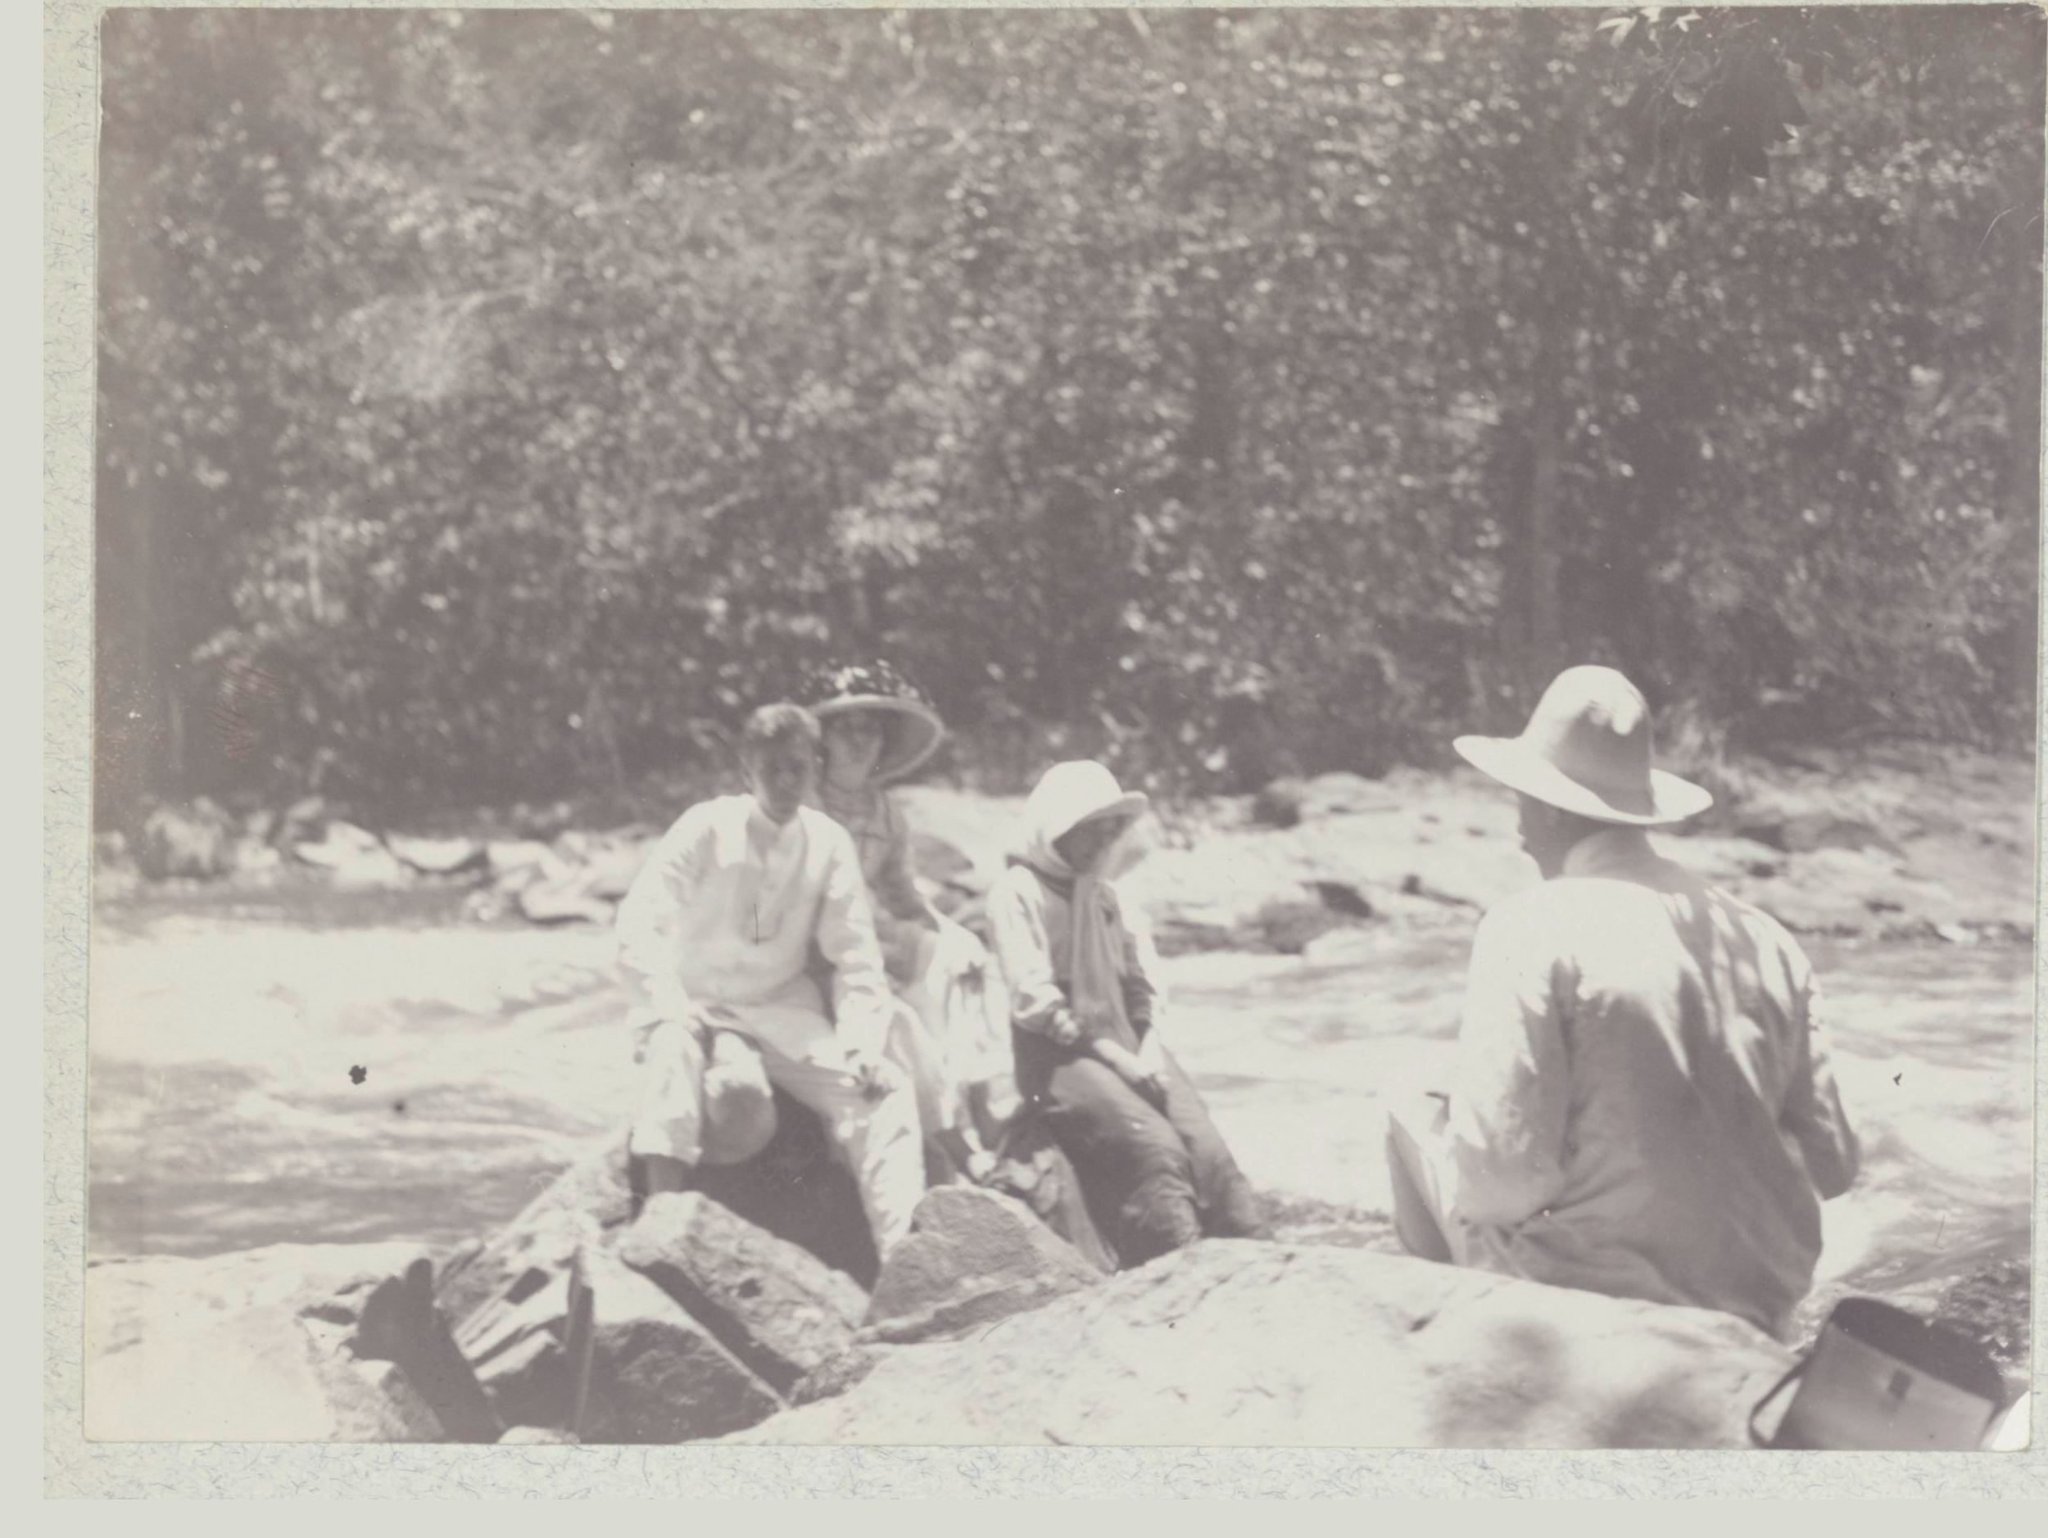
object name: photograph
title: Sarakreek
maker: Anonymous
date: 1909-1911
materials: photographic support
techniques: photography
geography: suriname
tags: suriname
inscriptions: inscription: ‘Sarakreek, Suriname. 1911’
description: Gezelschap bij de rotsen aan de waterkant van de Sarakreek, september 1911. Onderdeel van het fotoalbum van de familie Boom-Gonggrijp in Suriname en Curaçao.